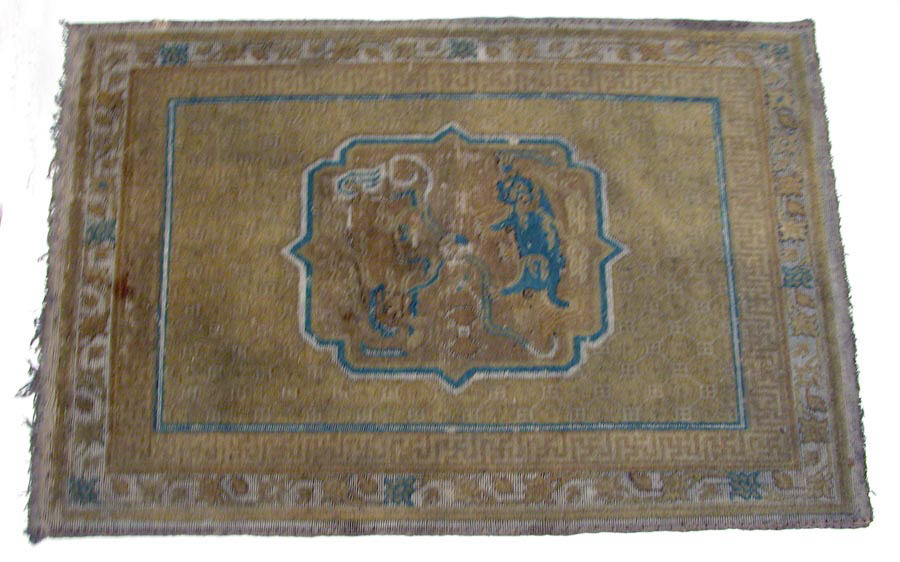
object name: kang rug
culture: chinese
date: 1601-1700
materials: cotton, wool